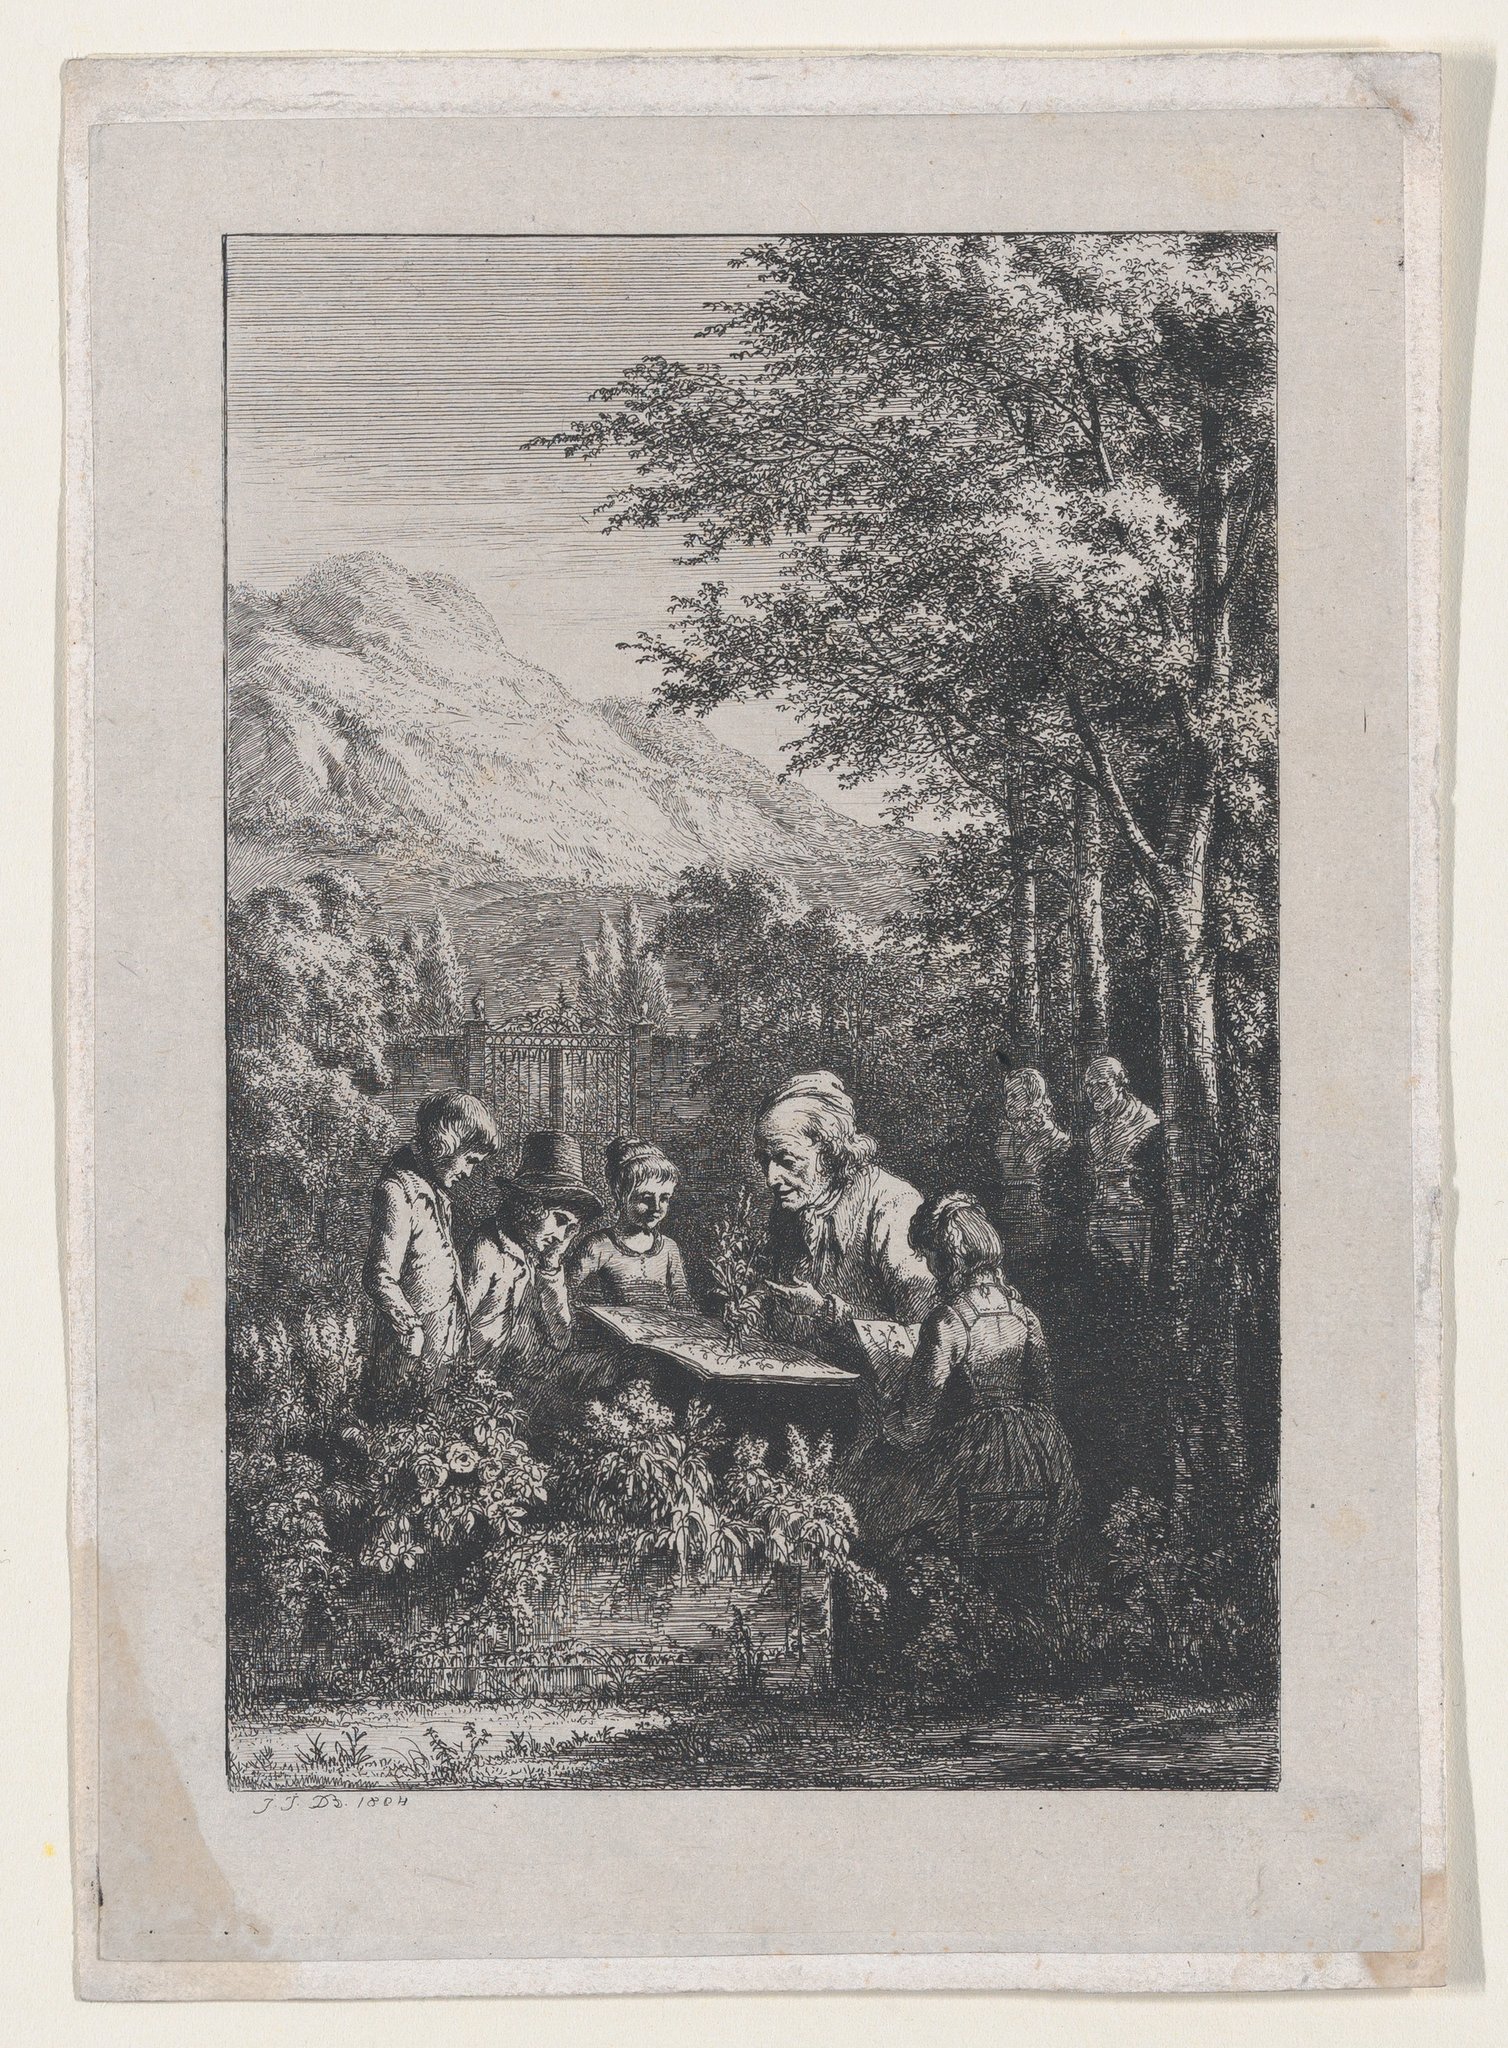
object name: print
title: The Botany Lesson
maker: jean jacques de boissieu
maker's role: artist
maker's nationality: french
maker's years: 1736-1810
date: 1804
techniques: drypoint, etching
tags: men,women,botany,students,teachers